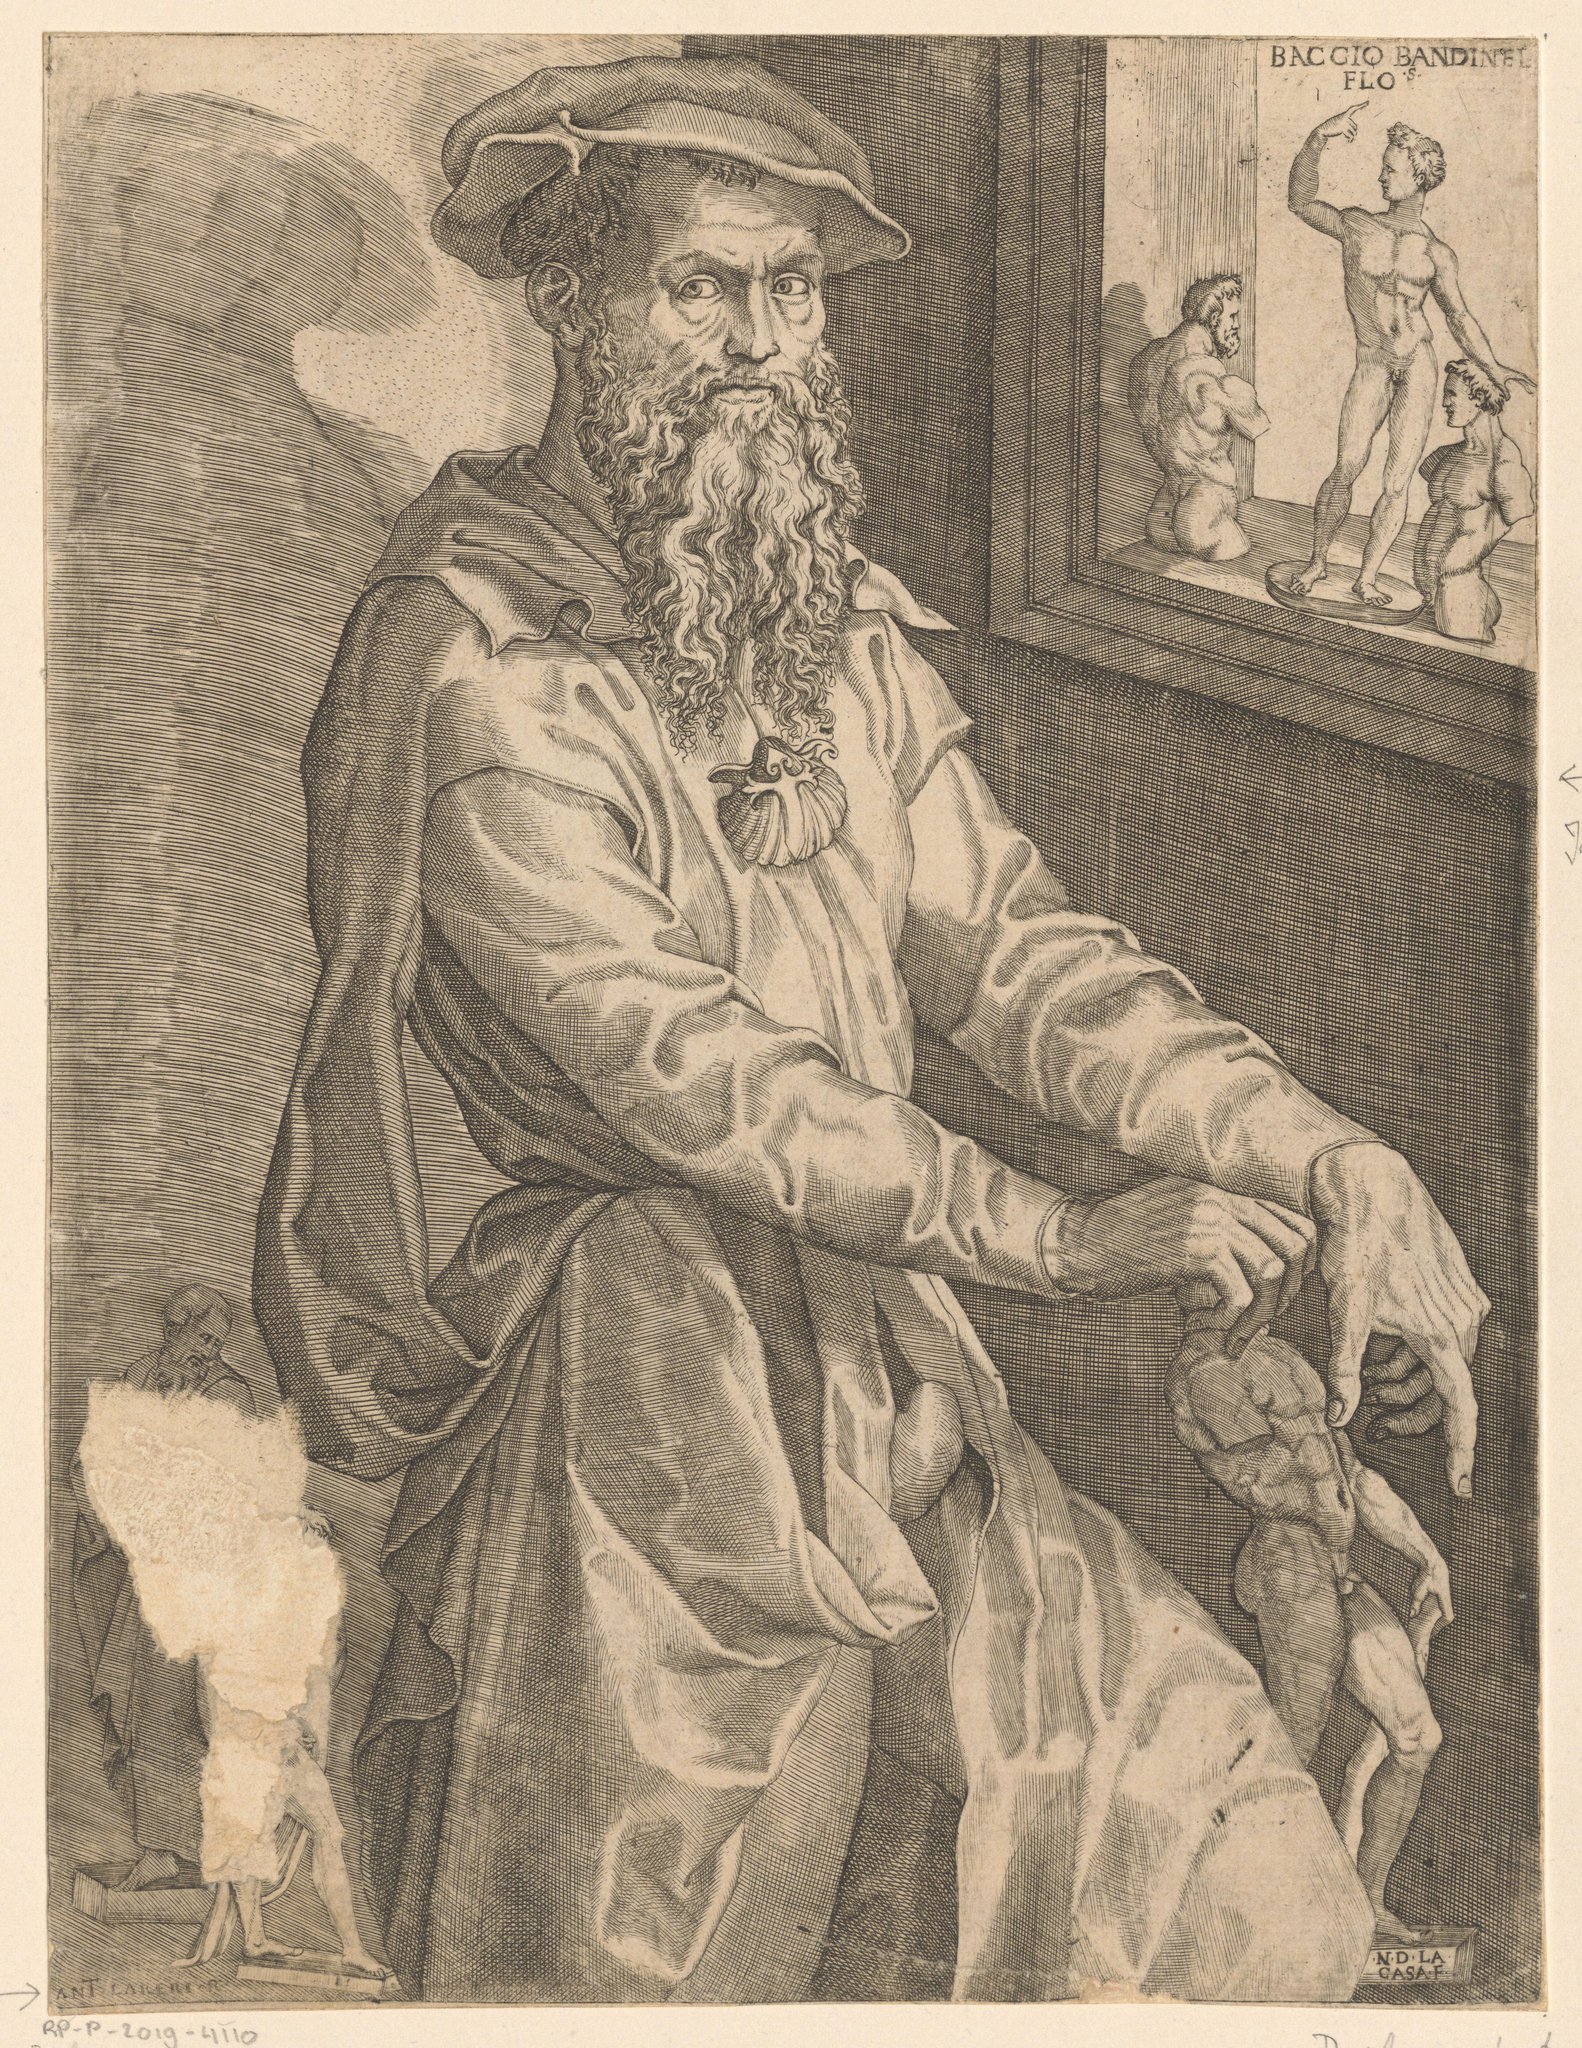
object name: print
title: Portret van Baccio Bandinelli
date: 1538-1552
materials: paper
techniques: engraving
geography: rome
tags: draughtsman, baccio bandinelli, portrait, self-portrait of sculptor, historical persons